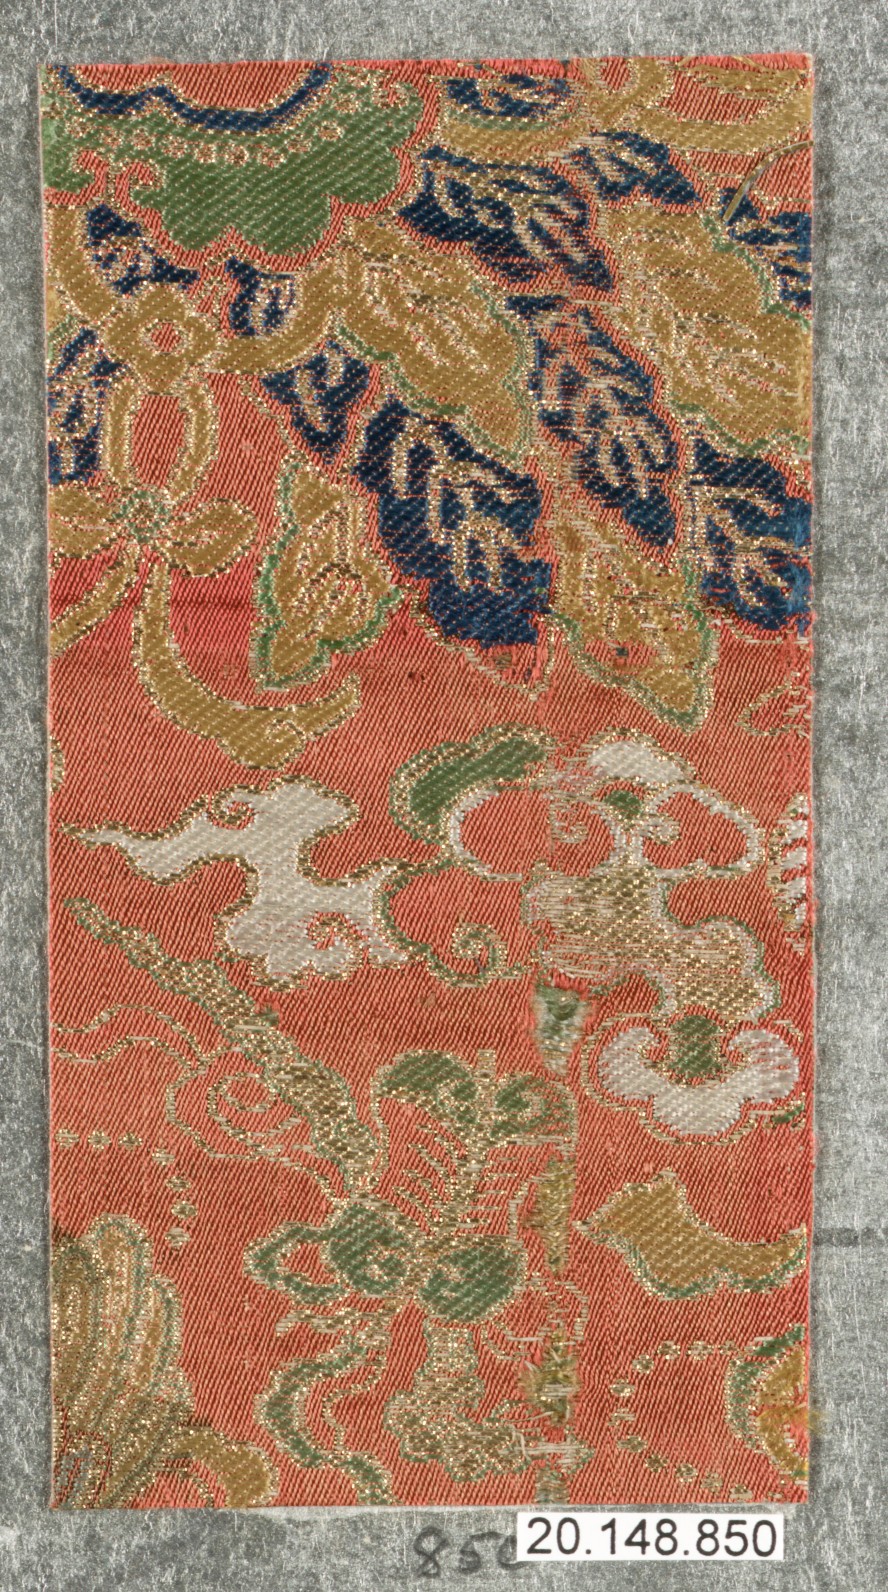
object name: piece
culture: japanese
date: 1701-1800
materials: silk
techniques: compound weave